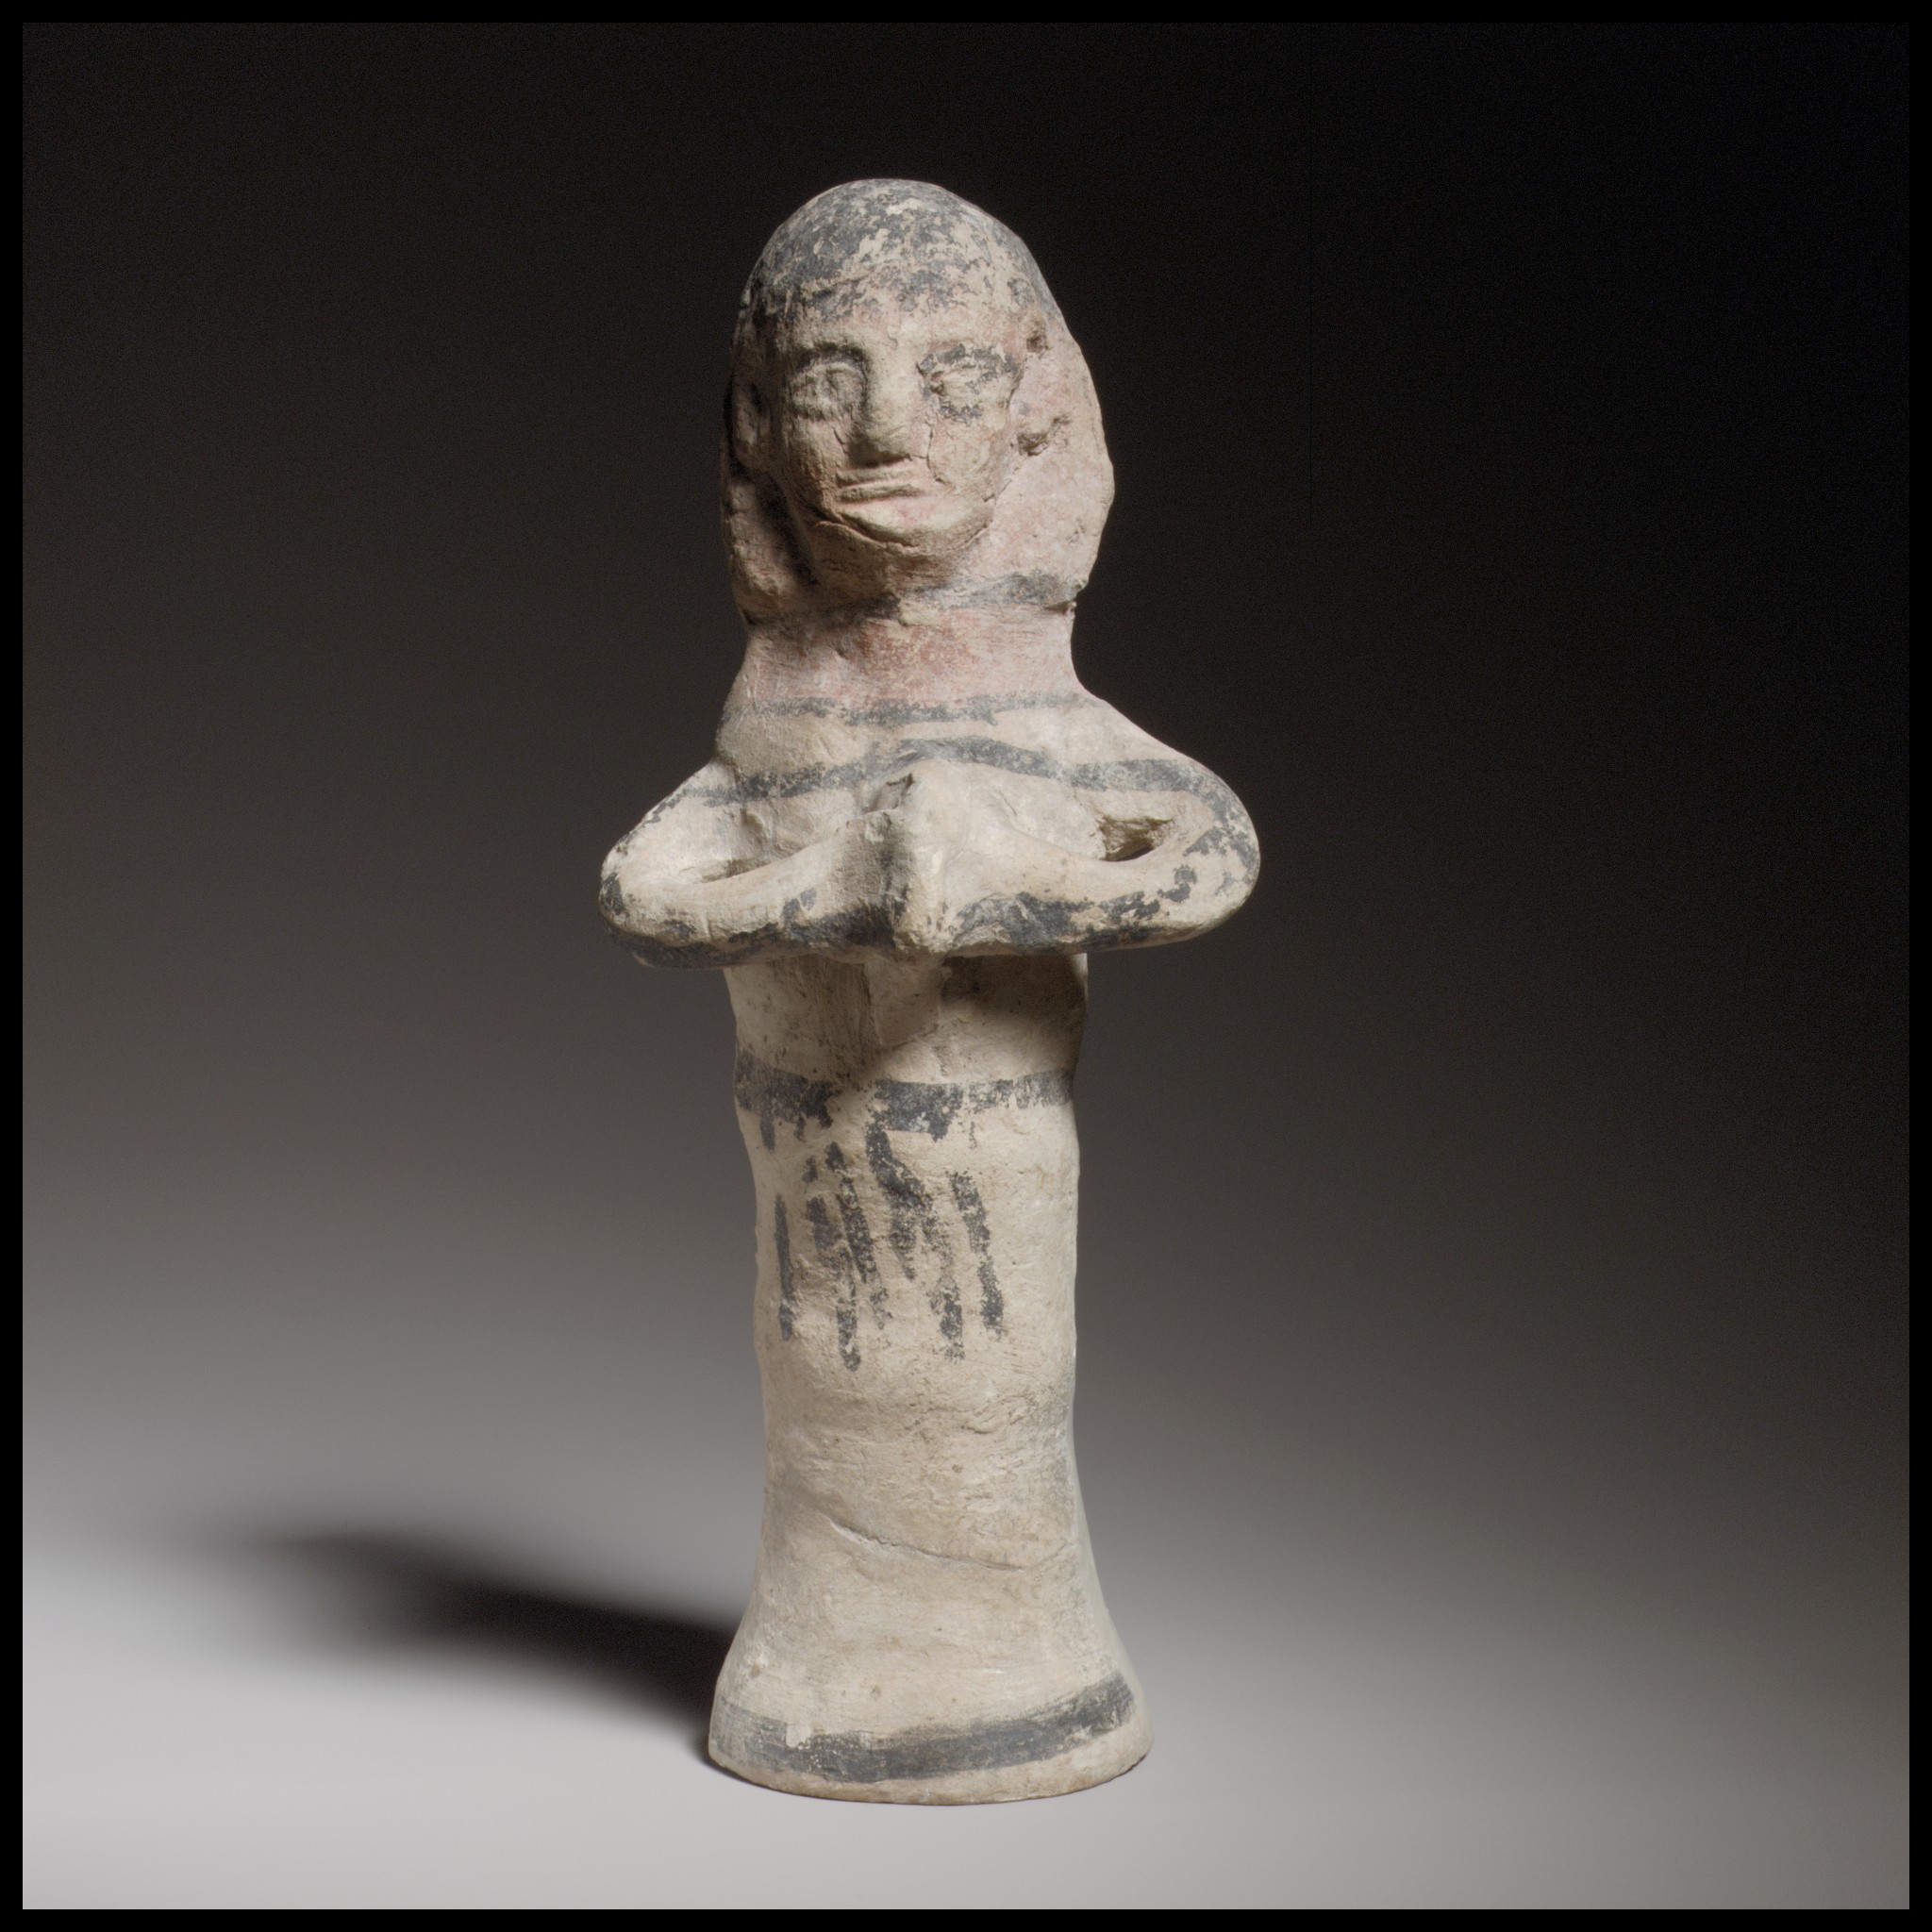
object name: statuette of a votary, female, playing tambourine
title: Standing tambourine player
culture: cypriot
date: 600-480 BCE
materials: terracotta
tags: human figures,musical instruments,musicians